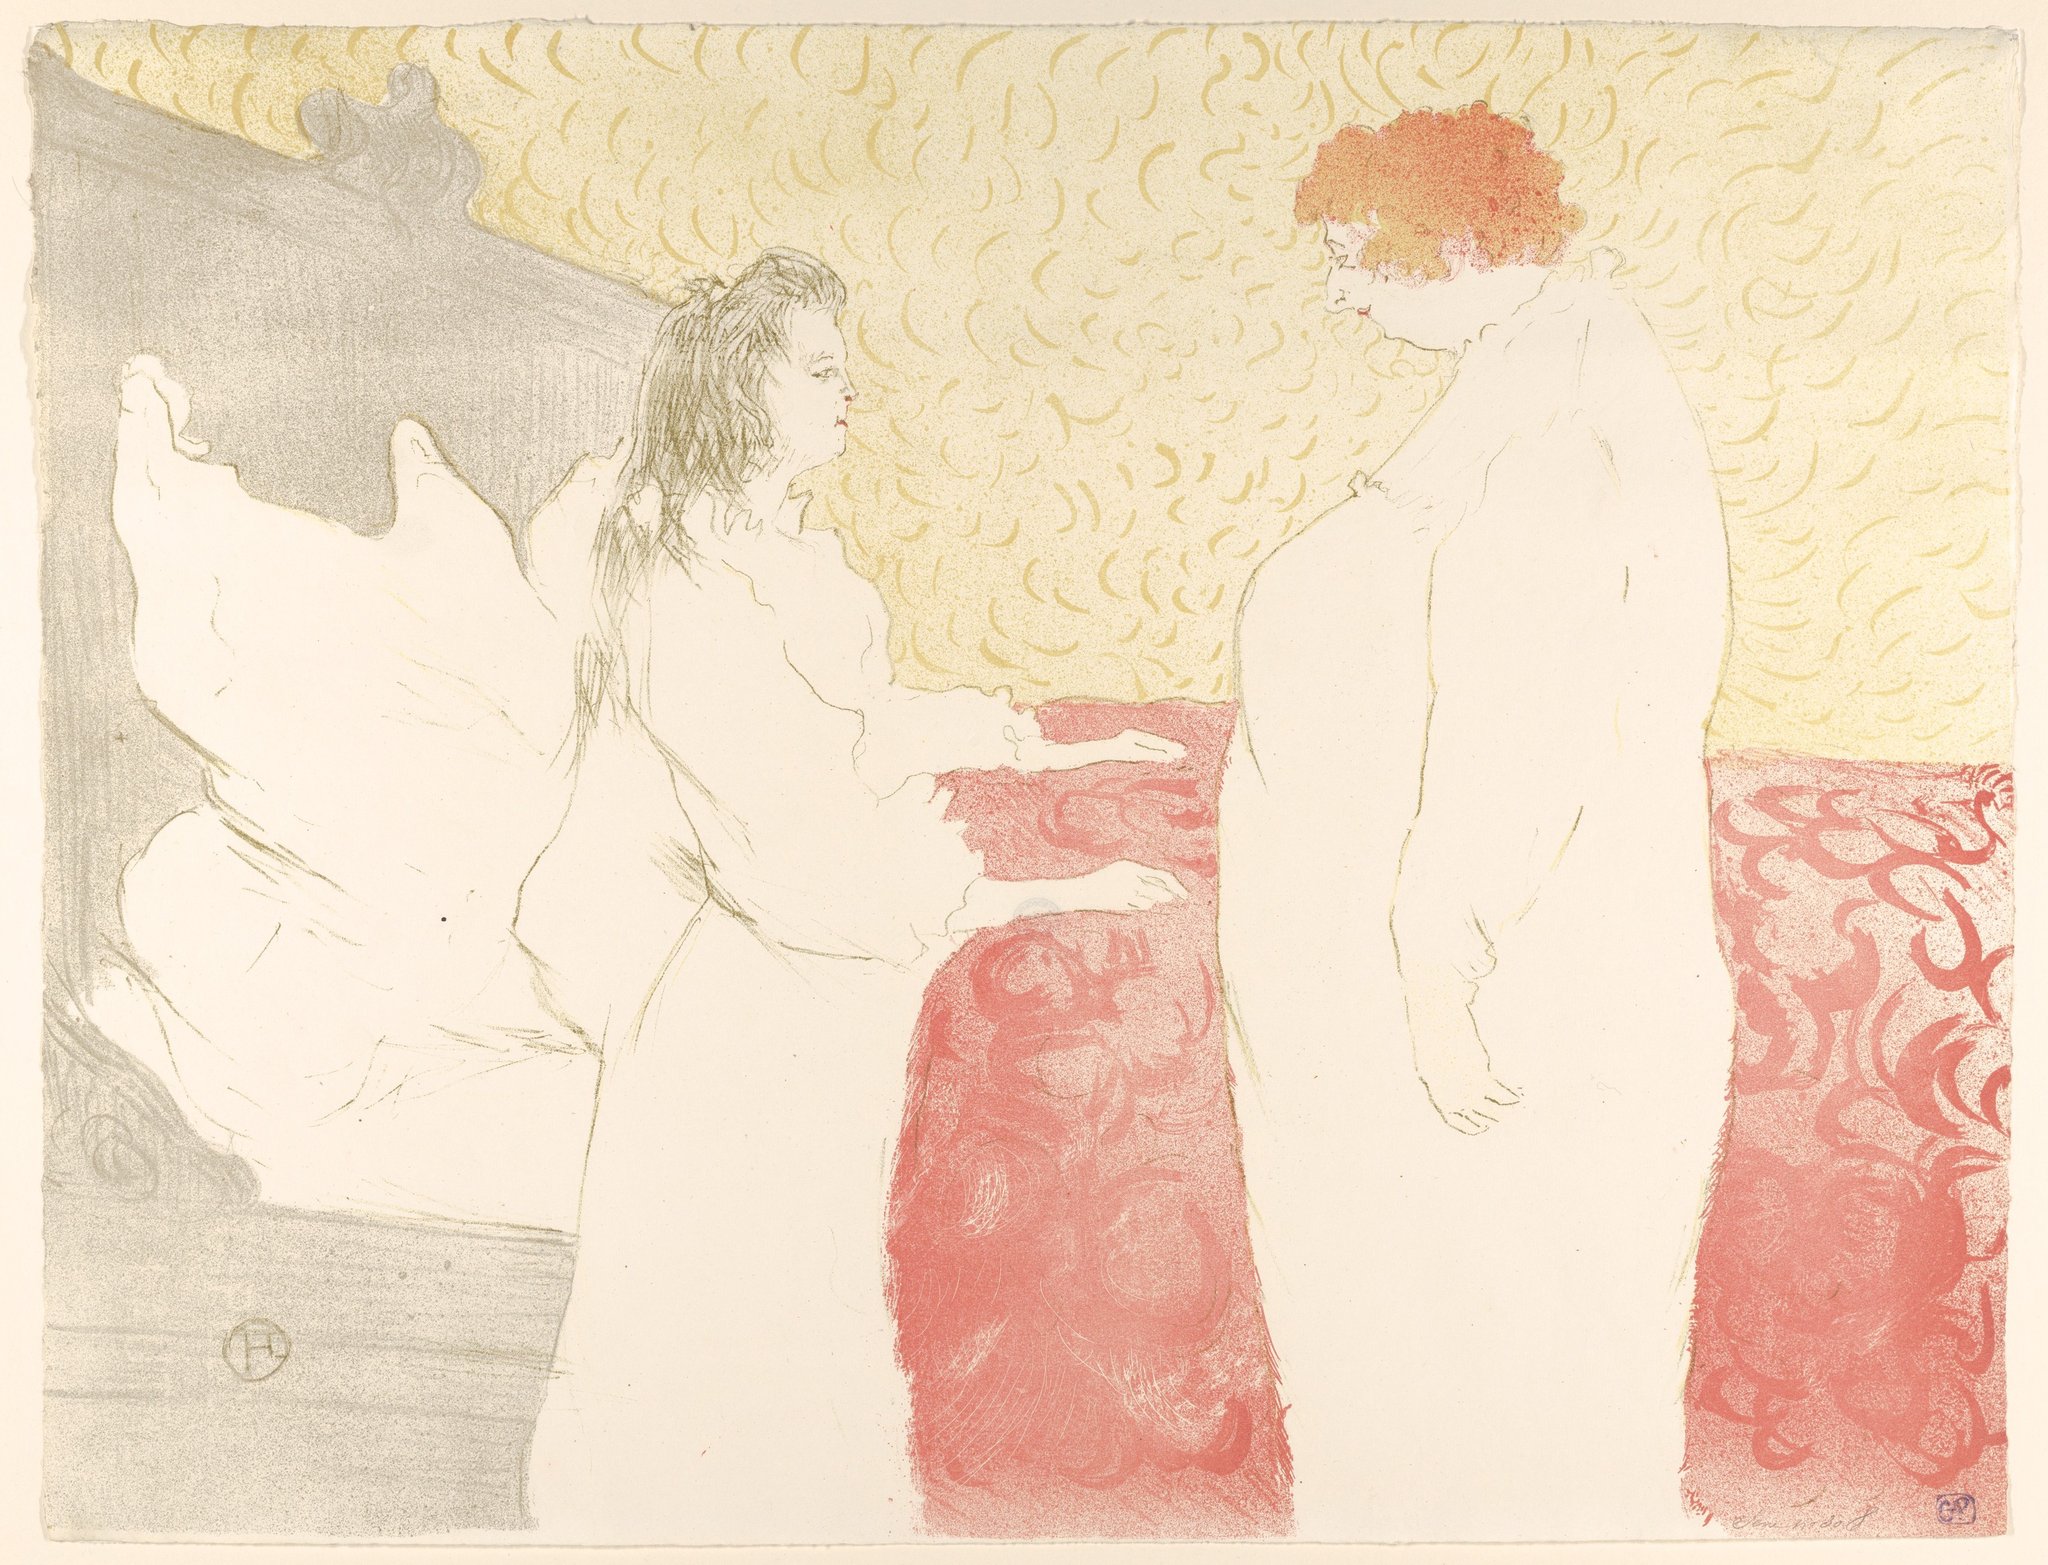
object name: print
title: Getting Up, from "Elles"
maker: henri de toulouse-lautrec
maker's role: artist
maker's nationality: french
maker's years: 1864-1901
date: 1896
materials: crayon, paper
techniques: brush, lithograph, printing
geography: france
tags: women,beds